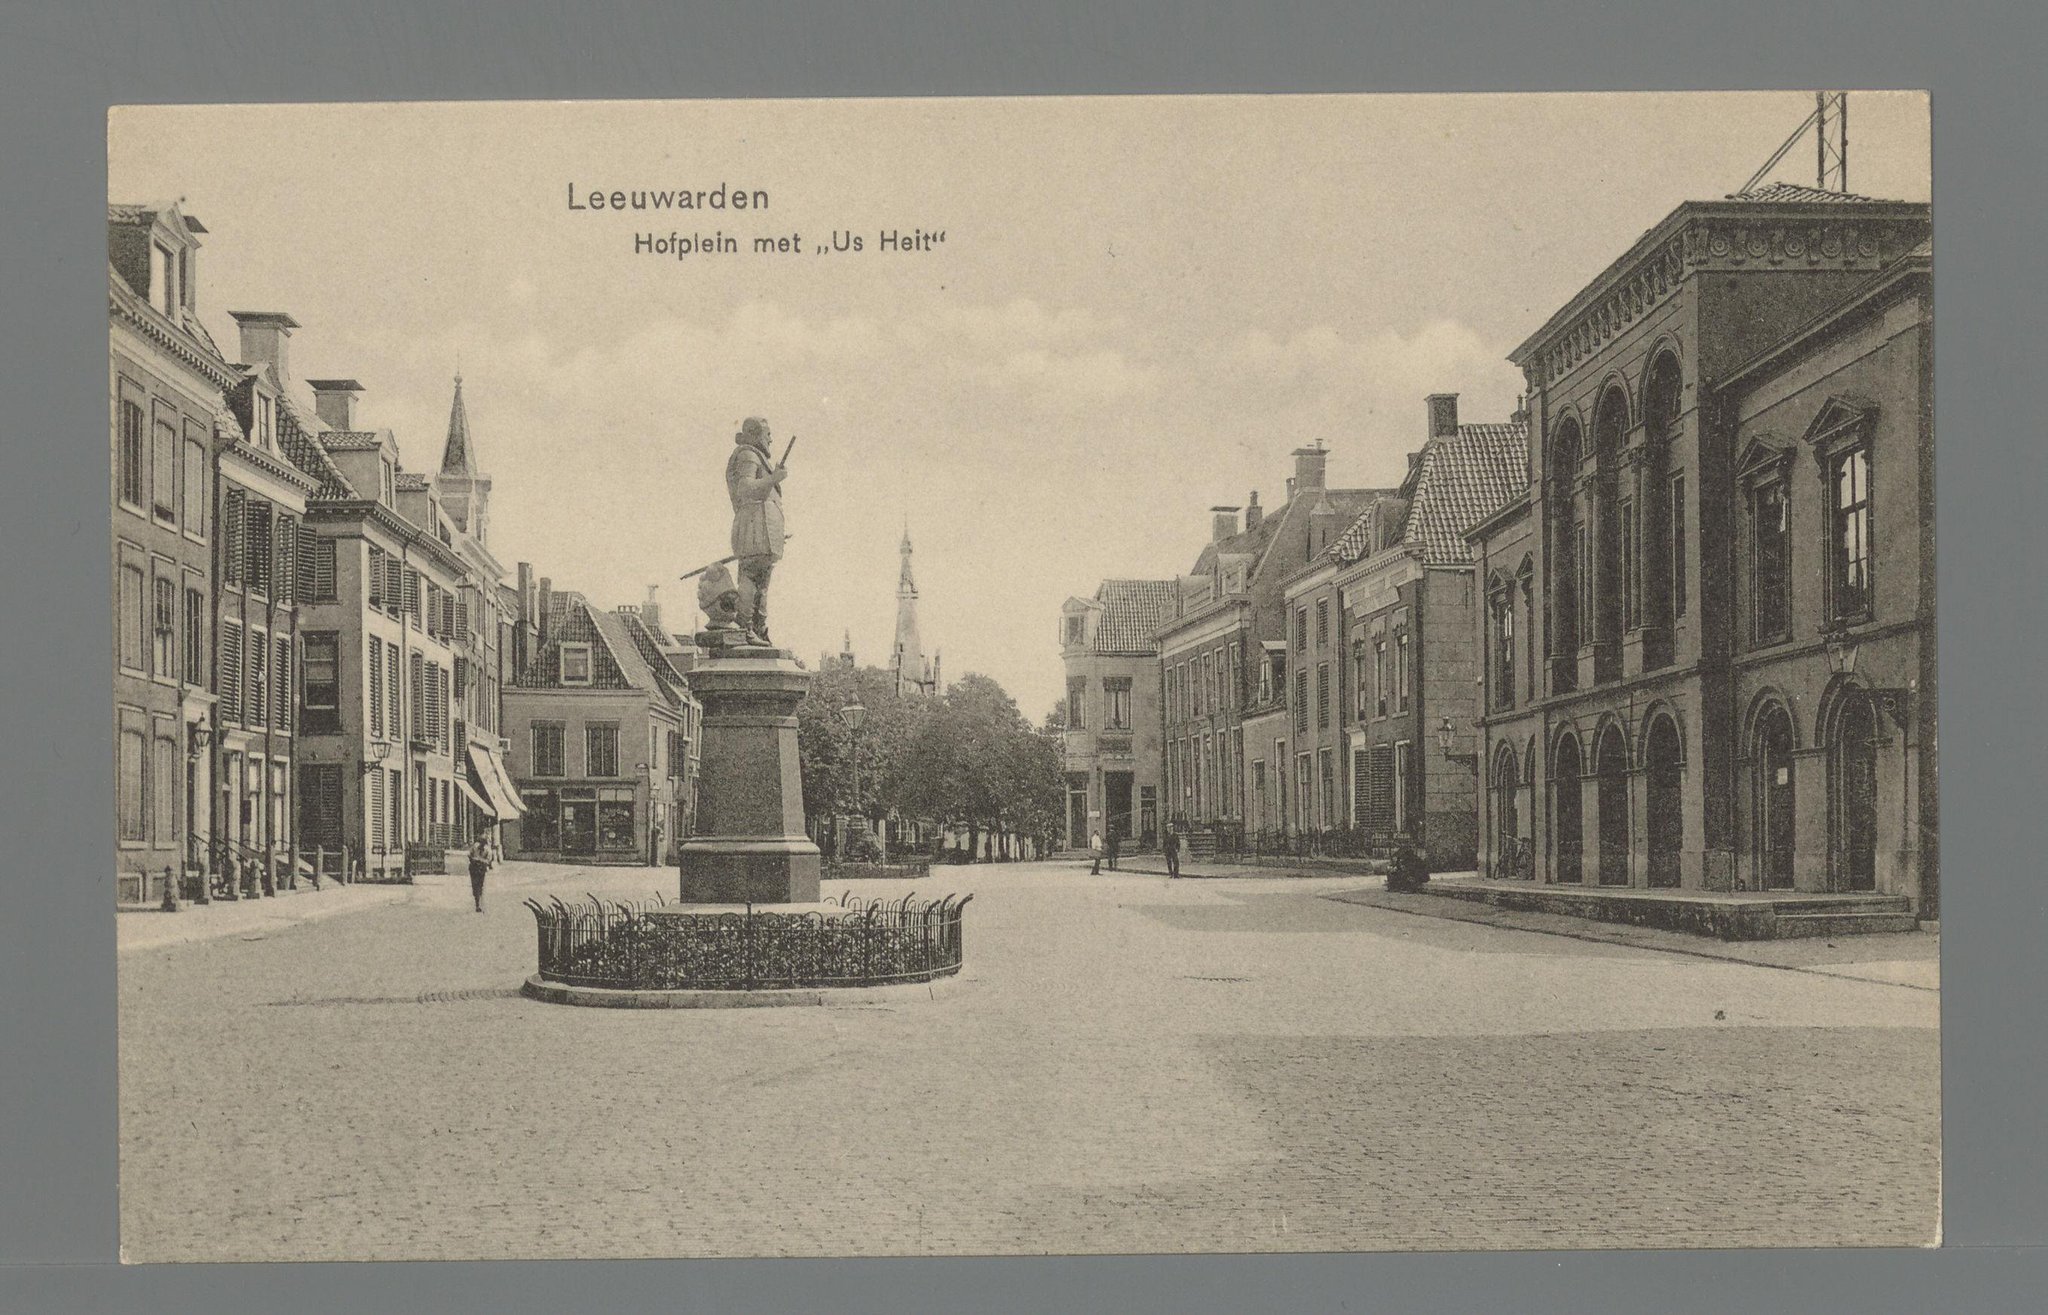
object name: photomechanical print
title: Leeuwarden. Hofplein met "Us Heit"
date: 1914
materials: cardboard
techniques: photograph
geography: leeuwarden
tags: willem lodewijk graaf van nassau-dillenburg, square, place, circus, etc., monument, statue, parts of church exterior and annexes: tower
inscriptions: date